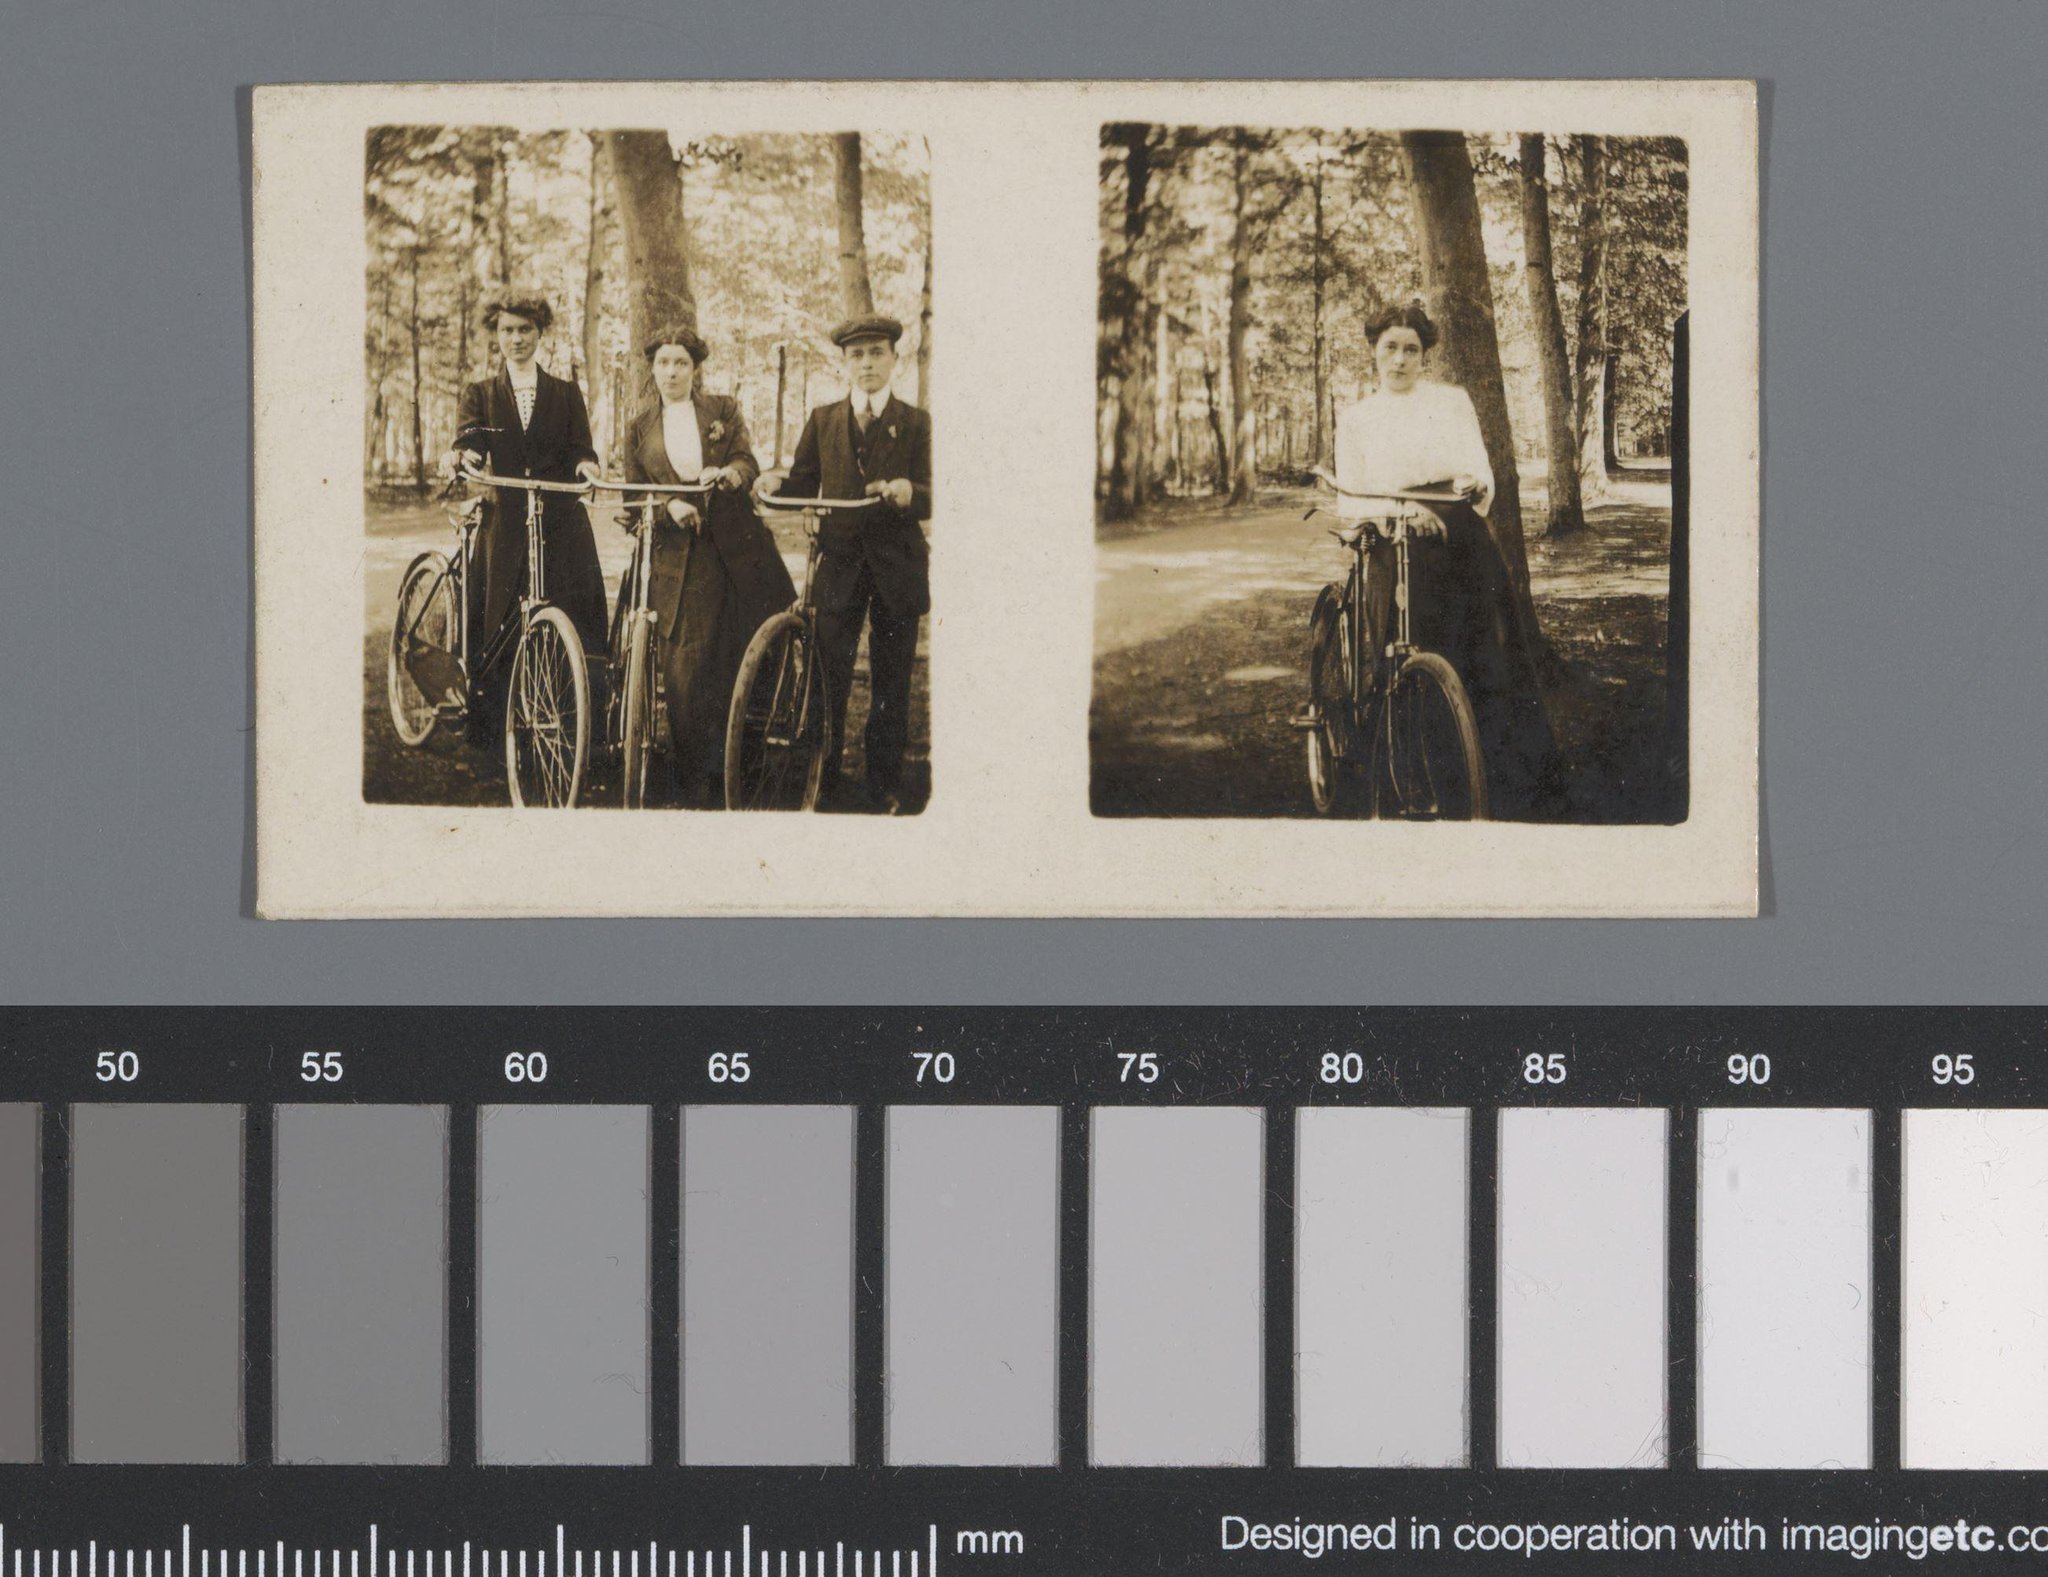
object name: photograph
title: Twee portretten van vier onbekende personen met fietsen in een bos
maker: Anonymous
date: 1910-1925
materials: photographic support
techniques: gelatin silver print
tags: adolescent, young woman, maiden, forest, wood, bicycle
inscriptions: inscription: ‘De[...]s + V Soesten’